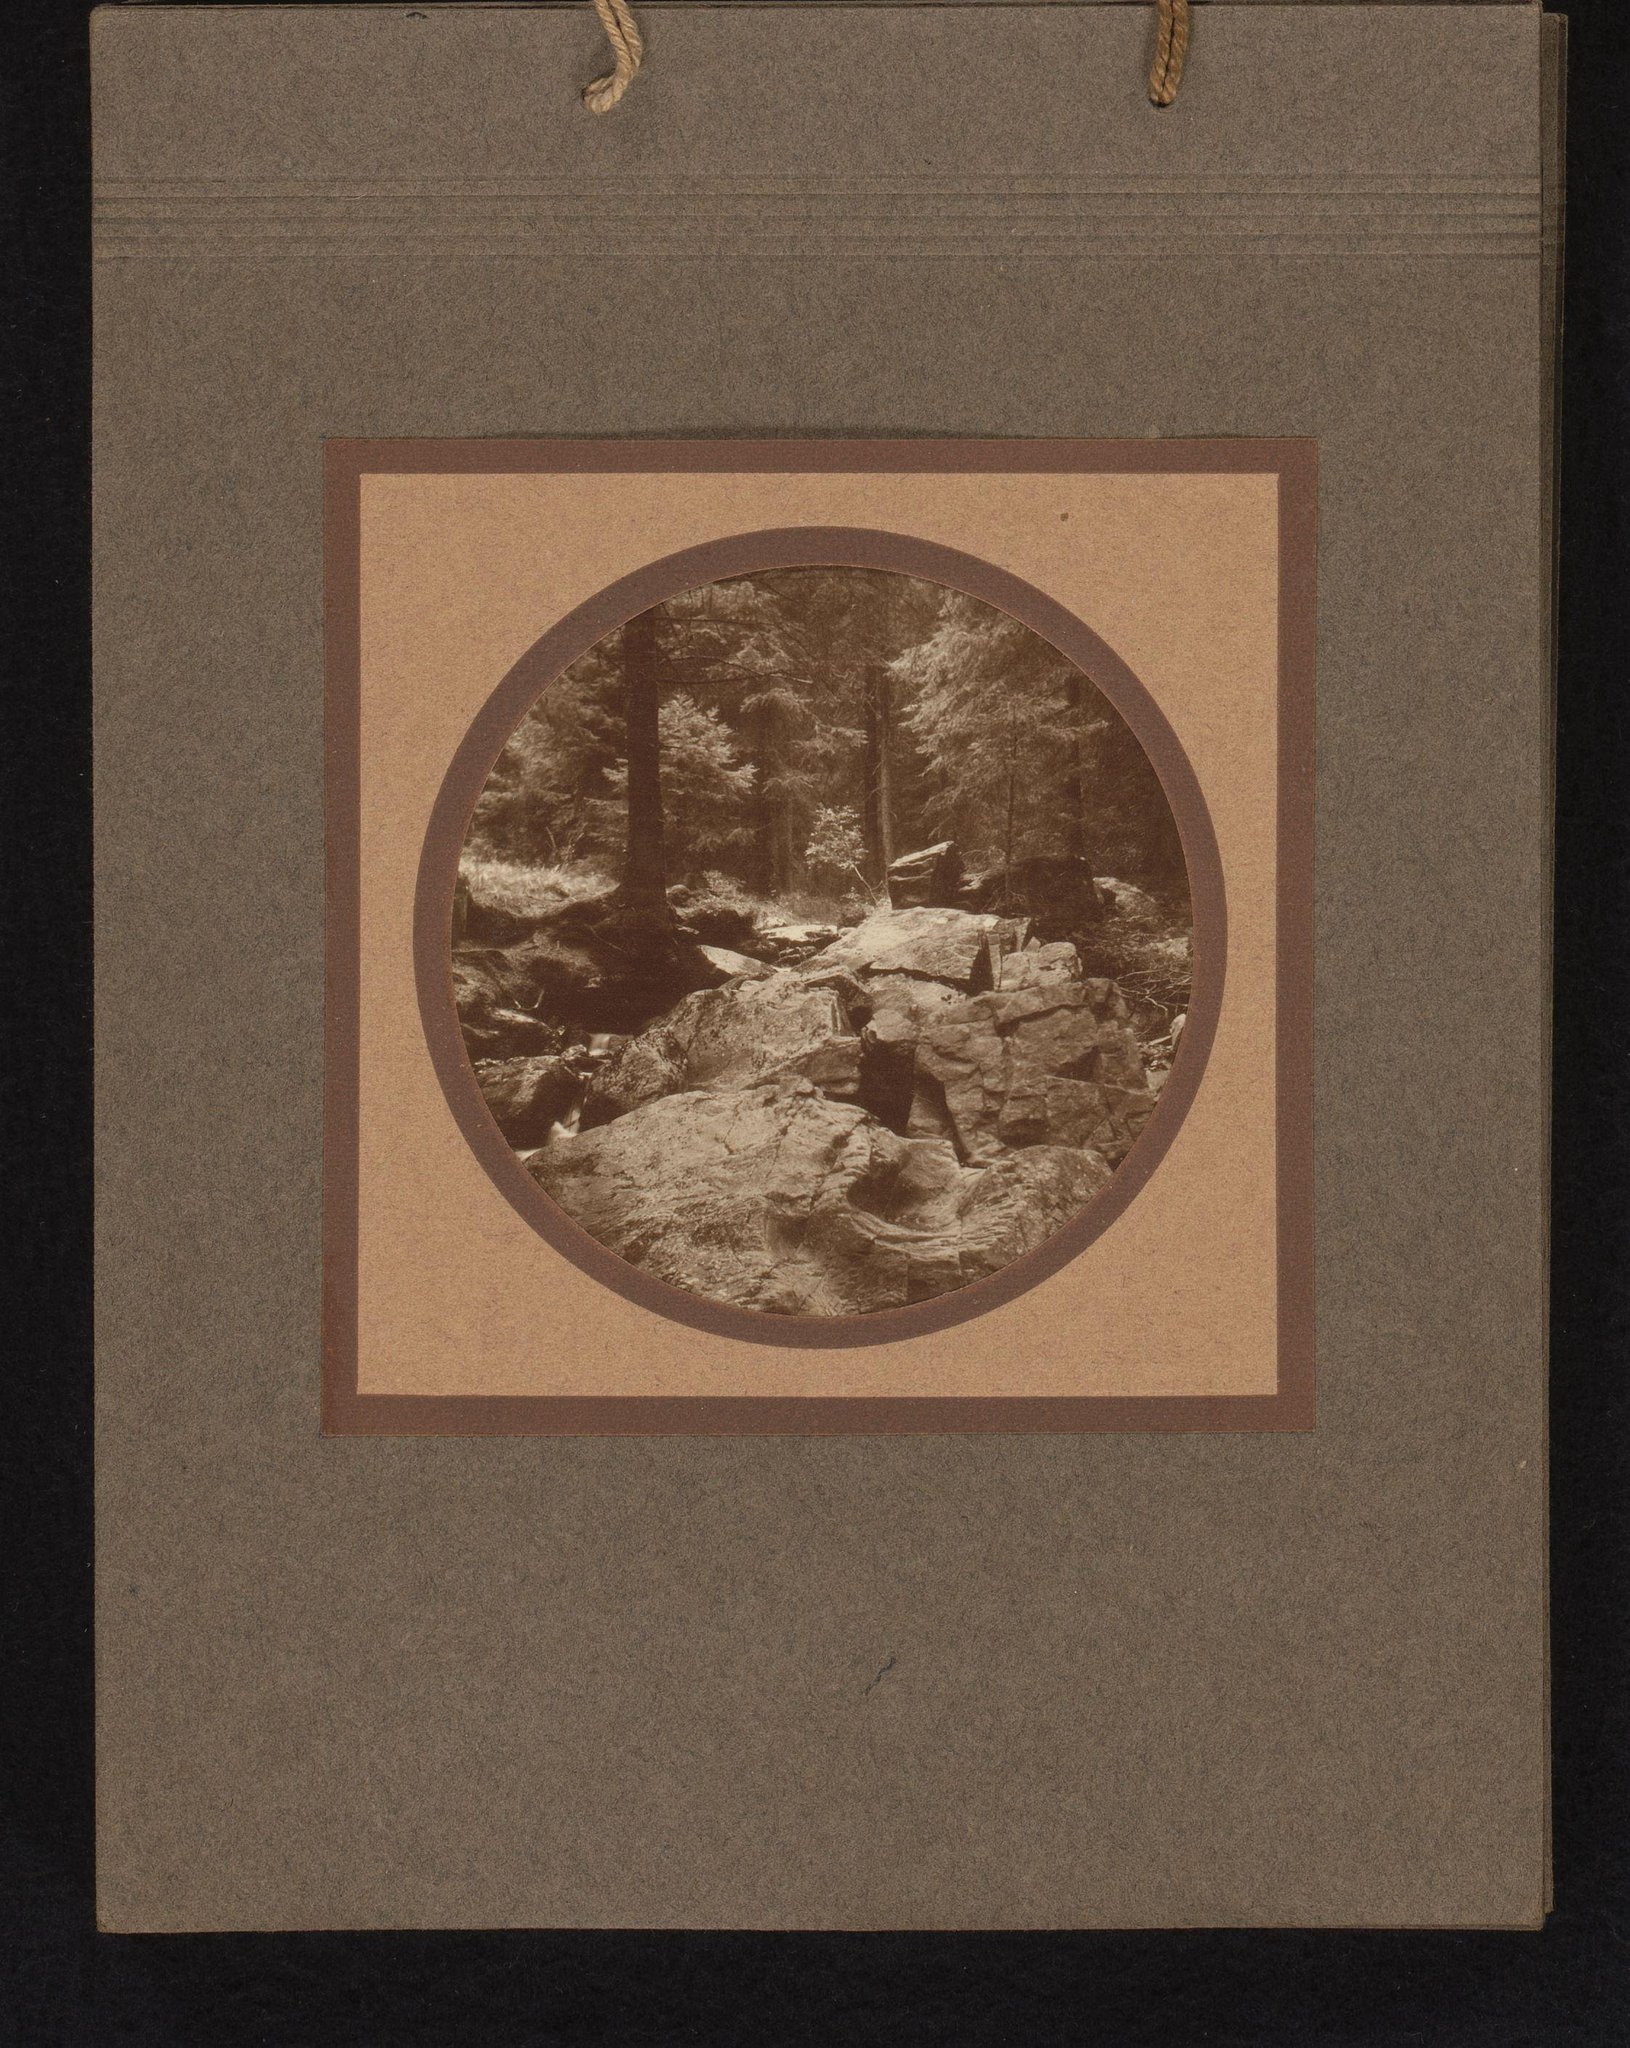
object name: album leaf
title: Rotsen in een bos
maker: Anonymous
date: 1880-1930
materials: cardboard, photographic support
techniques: collodion silver print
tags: forest, wood, rocks